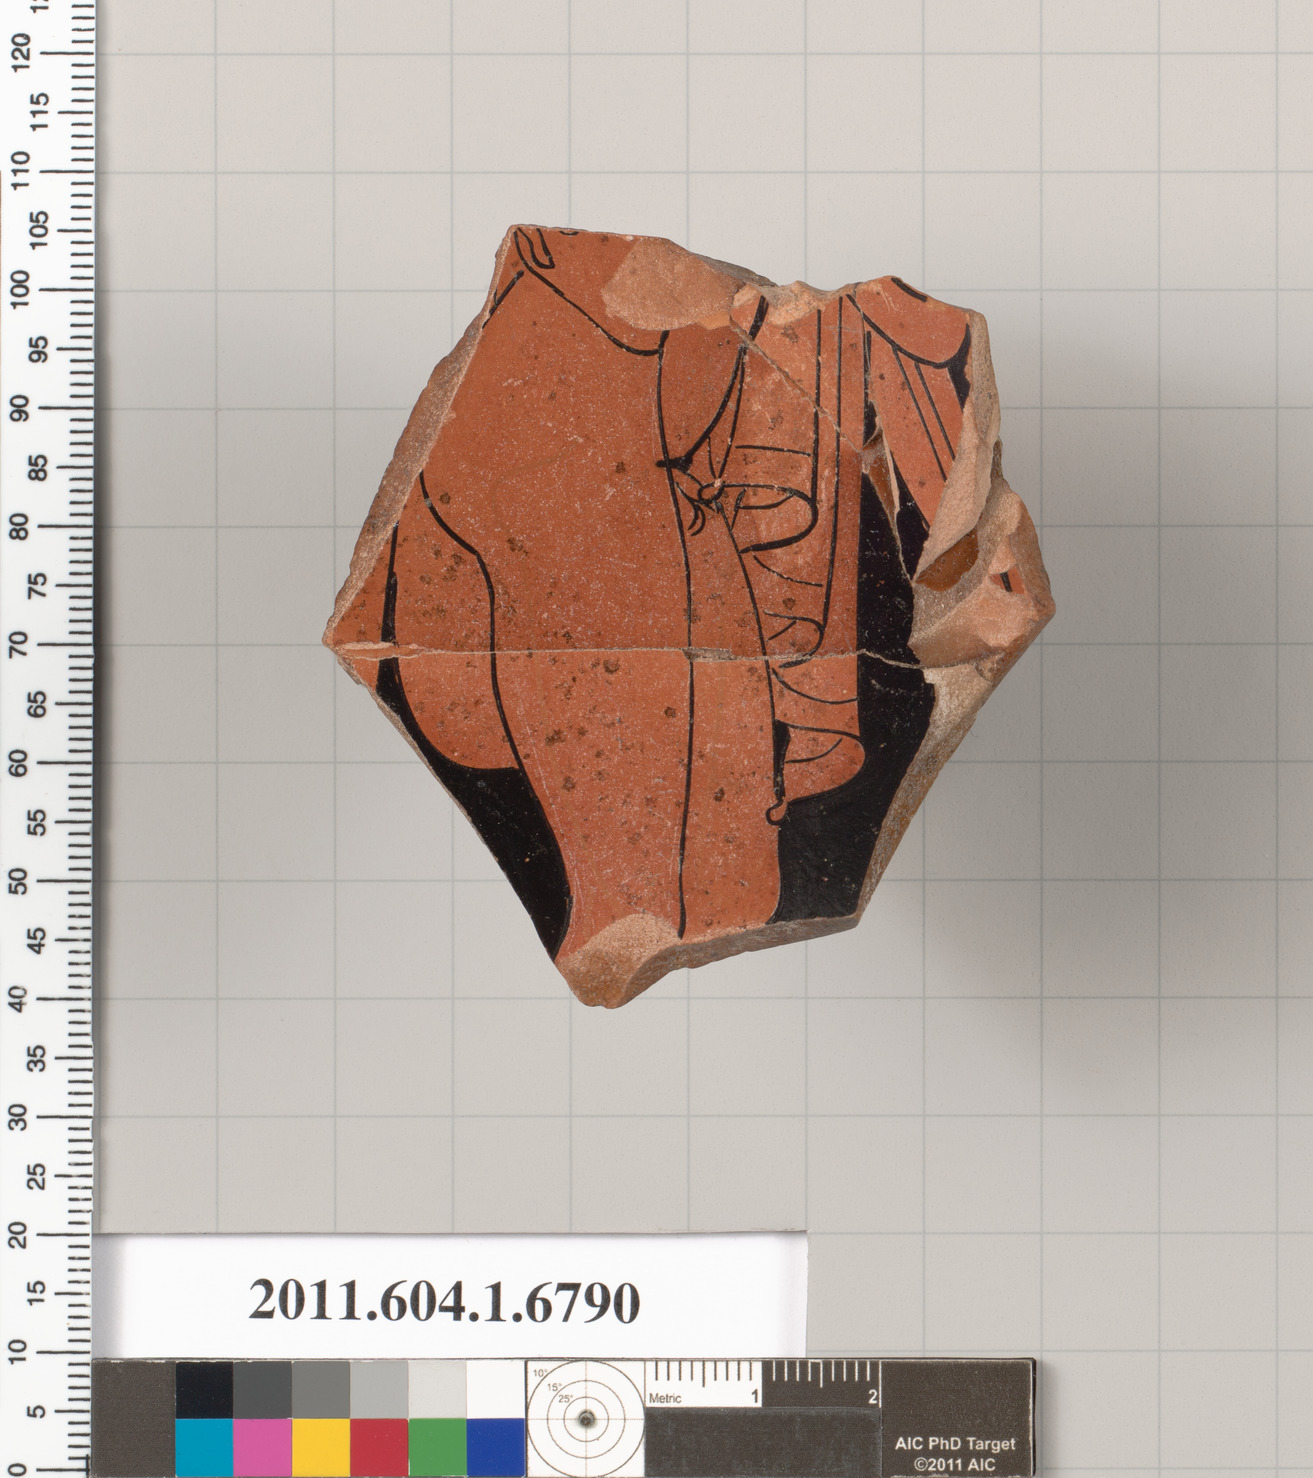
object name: kylix fragment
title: Terracotta fragment of a kylix (drinking cup)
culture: greek, attic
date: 490-470 BCE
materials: terracotta